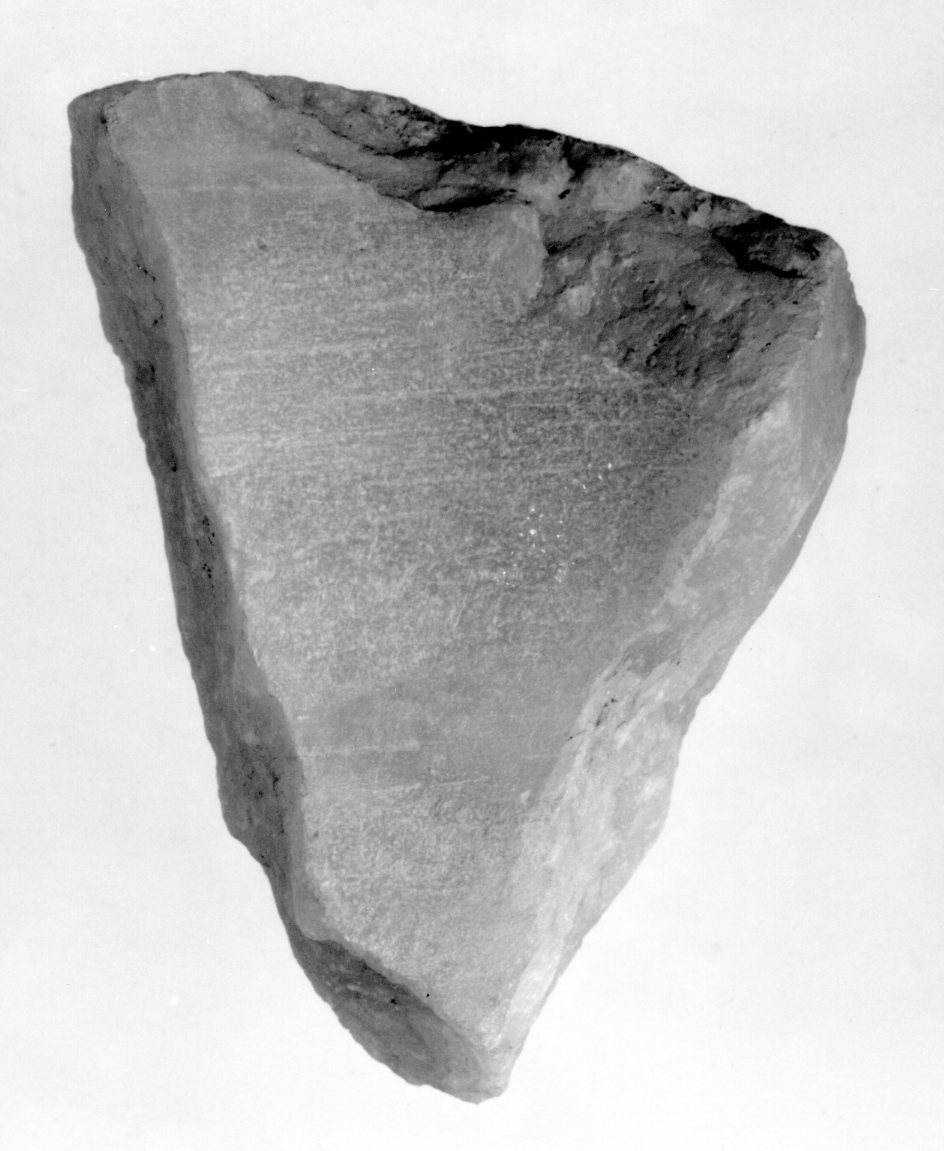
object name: canopic box, siptah, top surface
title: Fragment Preserving Both the Interior and Exterior Surfaces of Siptah's Canopic Chest.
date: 1194-1188 BCE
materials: stone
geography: egypt